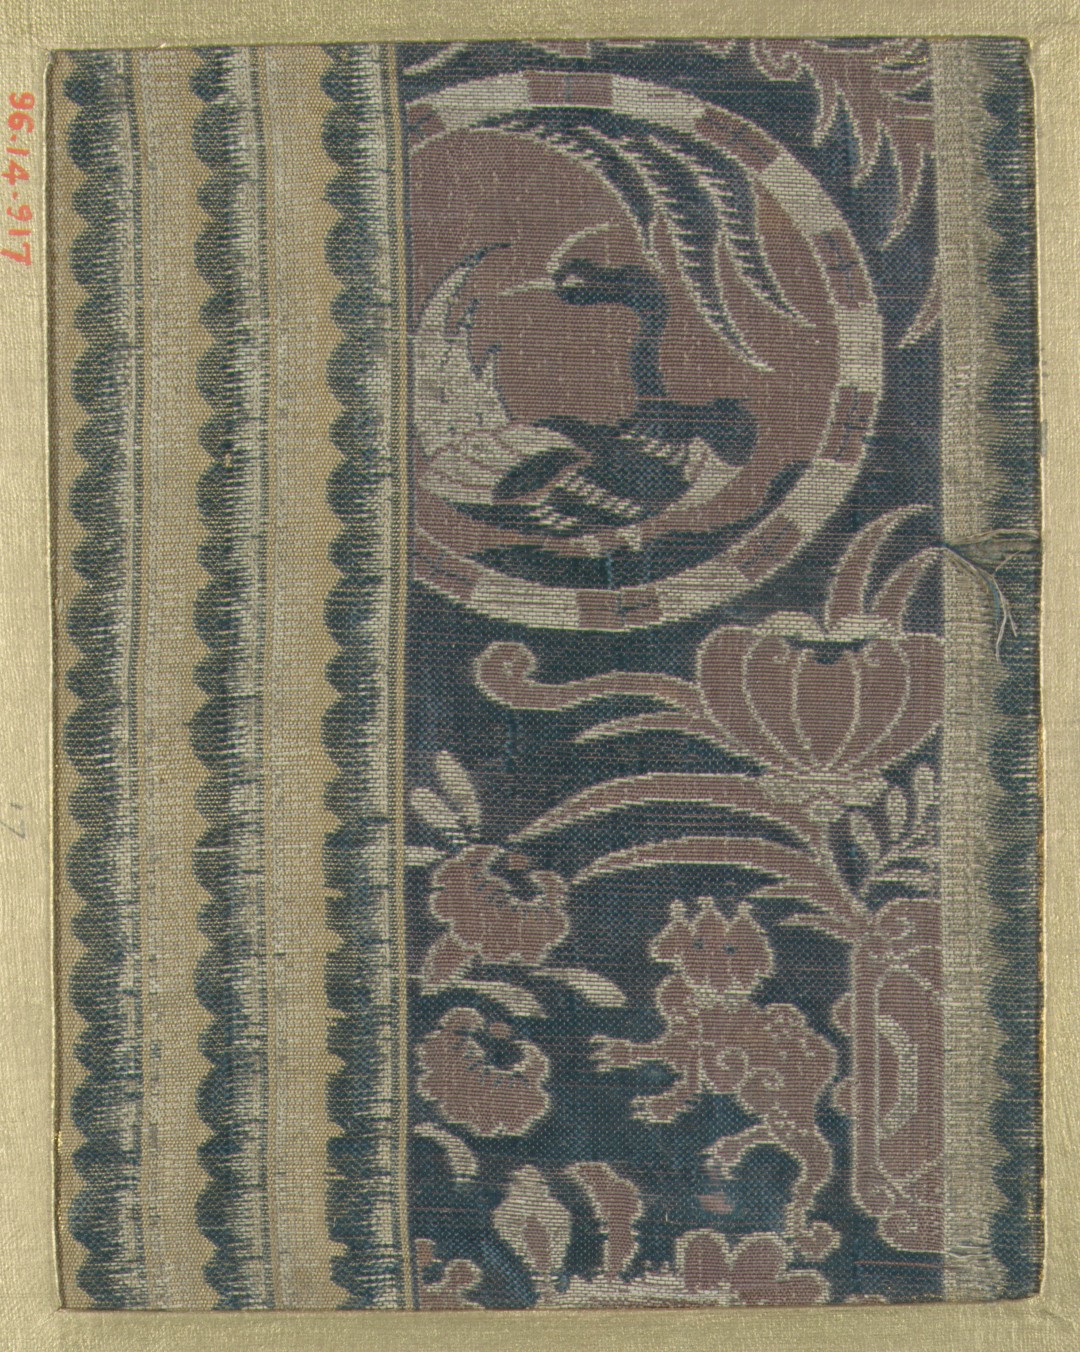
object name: piece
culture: japanese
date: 1701-1900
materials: silk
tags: mythical creatures,flowers